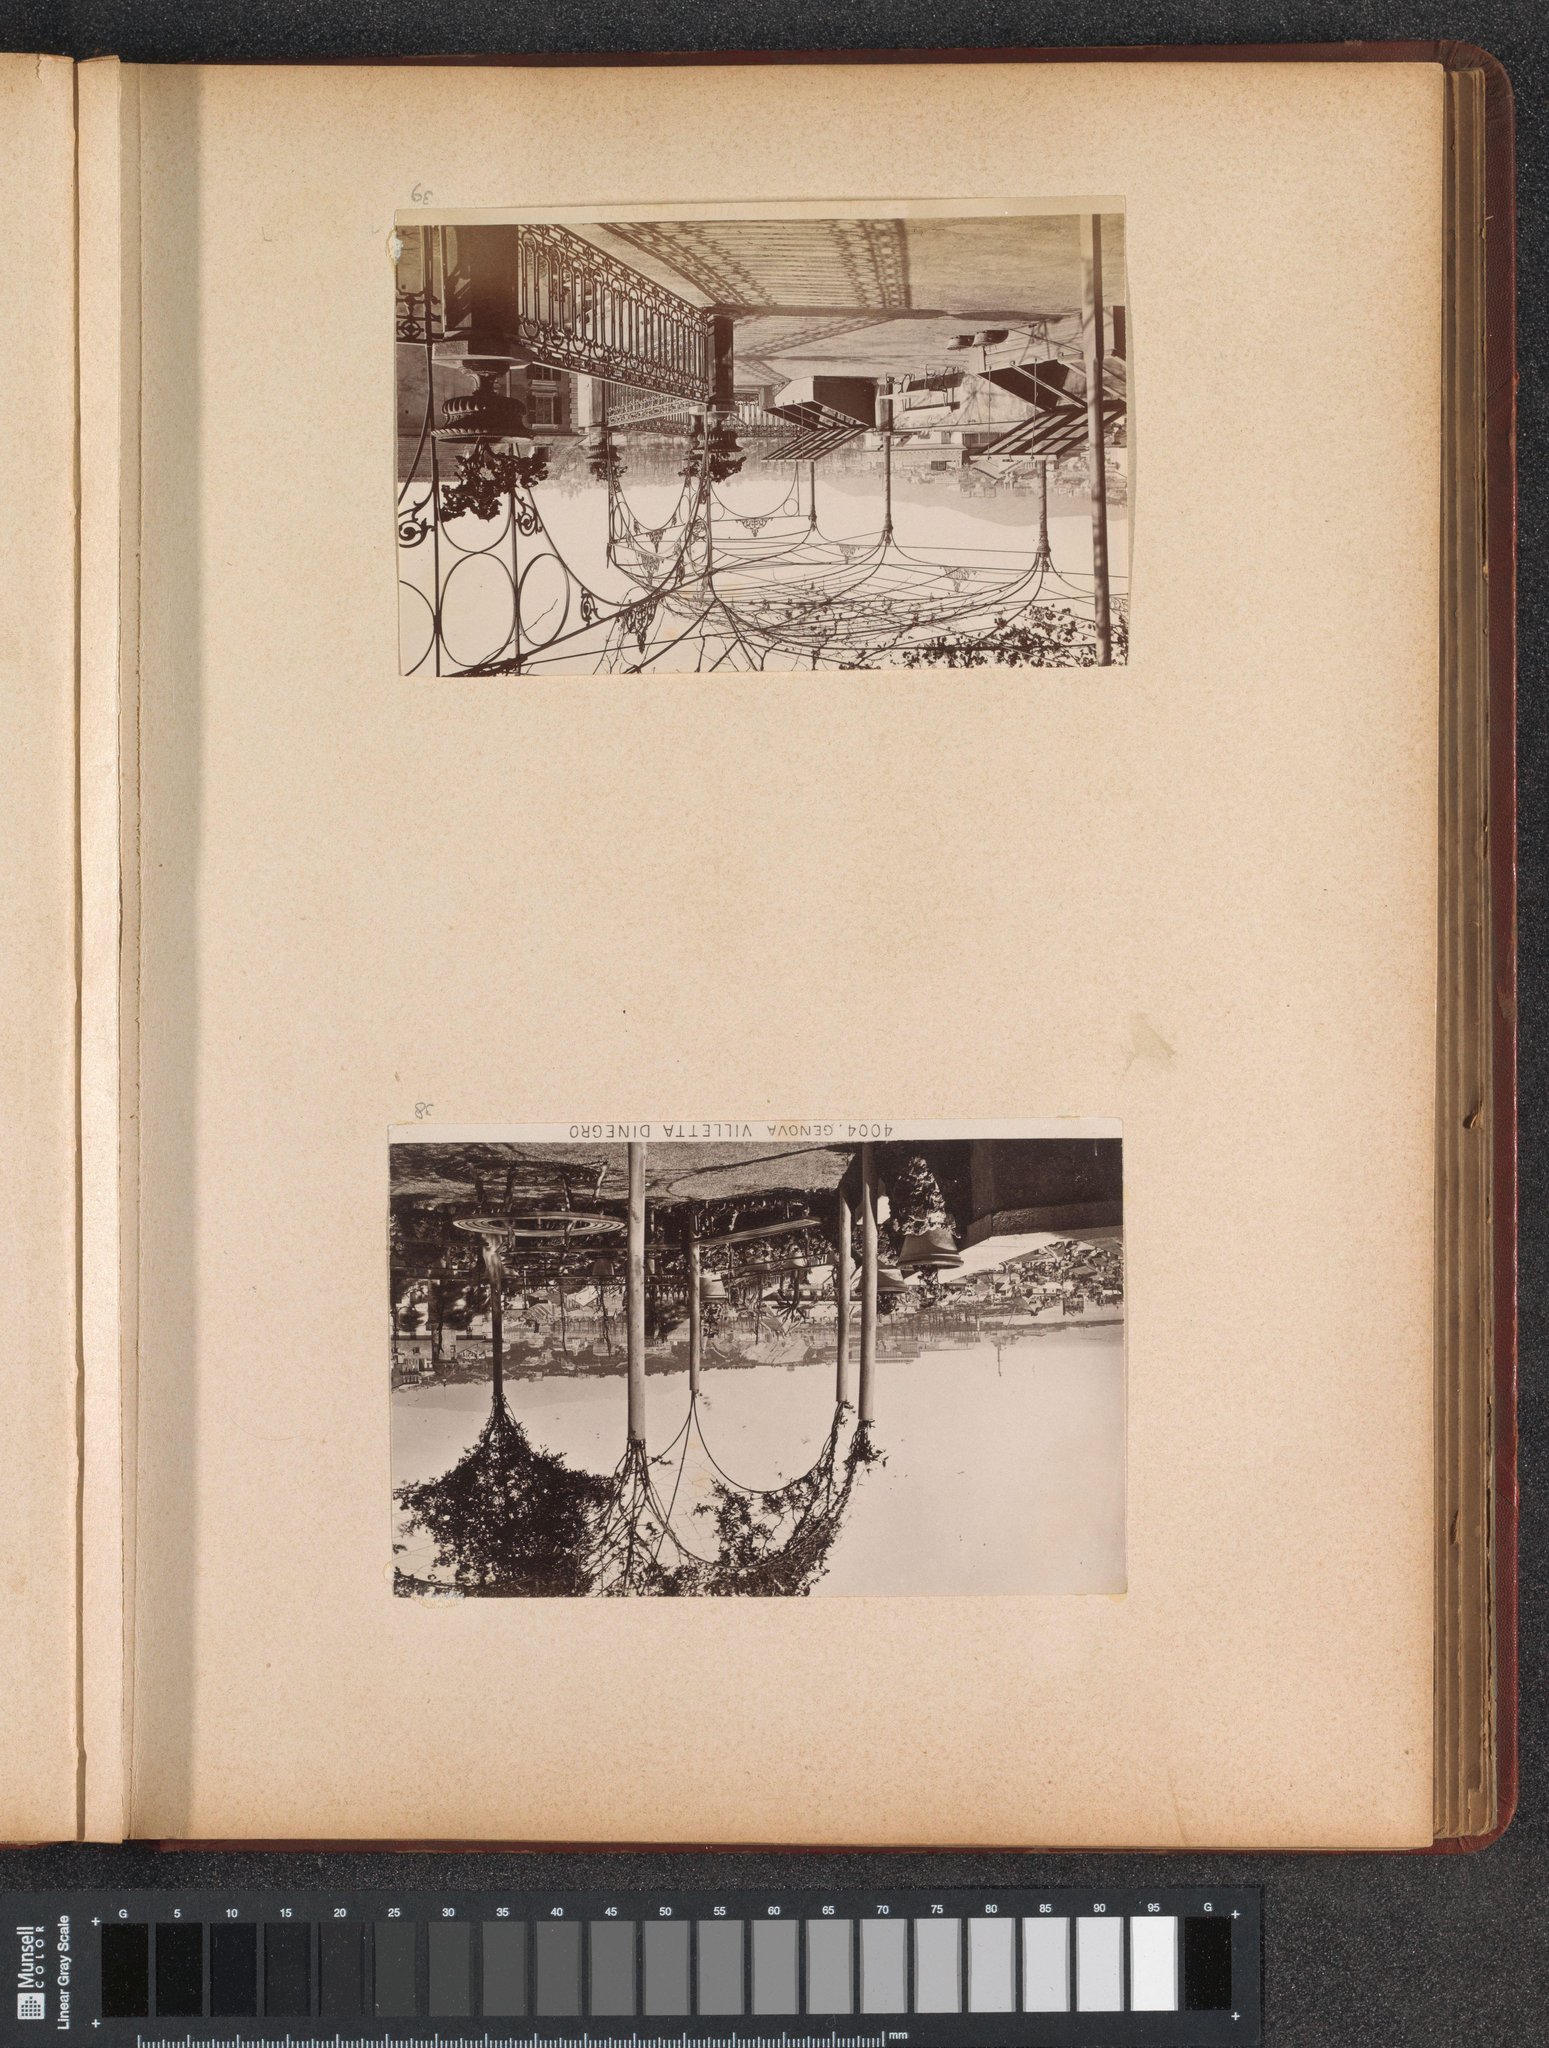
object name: album leaf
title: Gezicht op Genua vanuit Viletta Dinegro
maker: Anonymous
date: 1870-1900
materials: paper, photographic support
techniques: albumen print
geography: genoa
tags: villa, public gardens, park, prospect of city, town panorama, silhouette of city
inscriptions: negative number: ‘4004’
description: Onderdeel van Reisalbum met foto's van bezienswaardigheden in Italië en Zuid-Frankrijk.